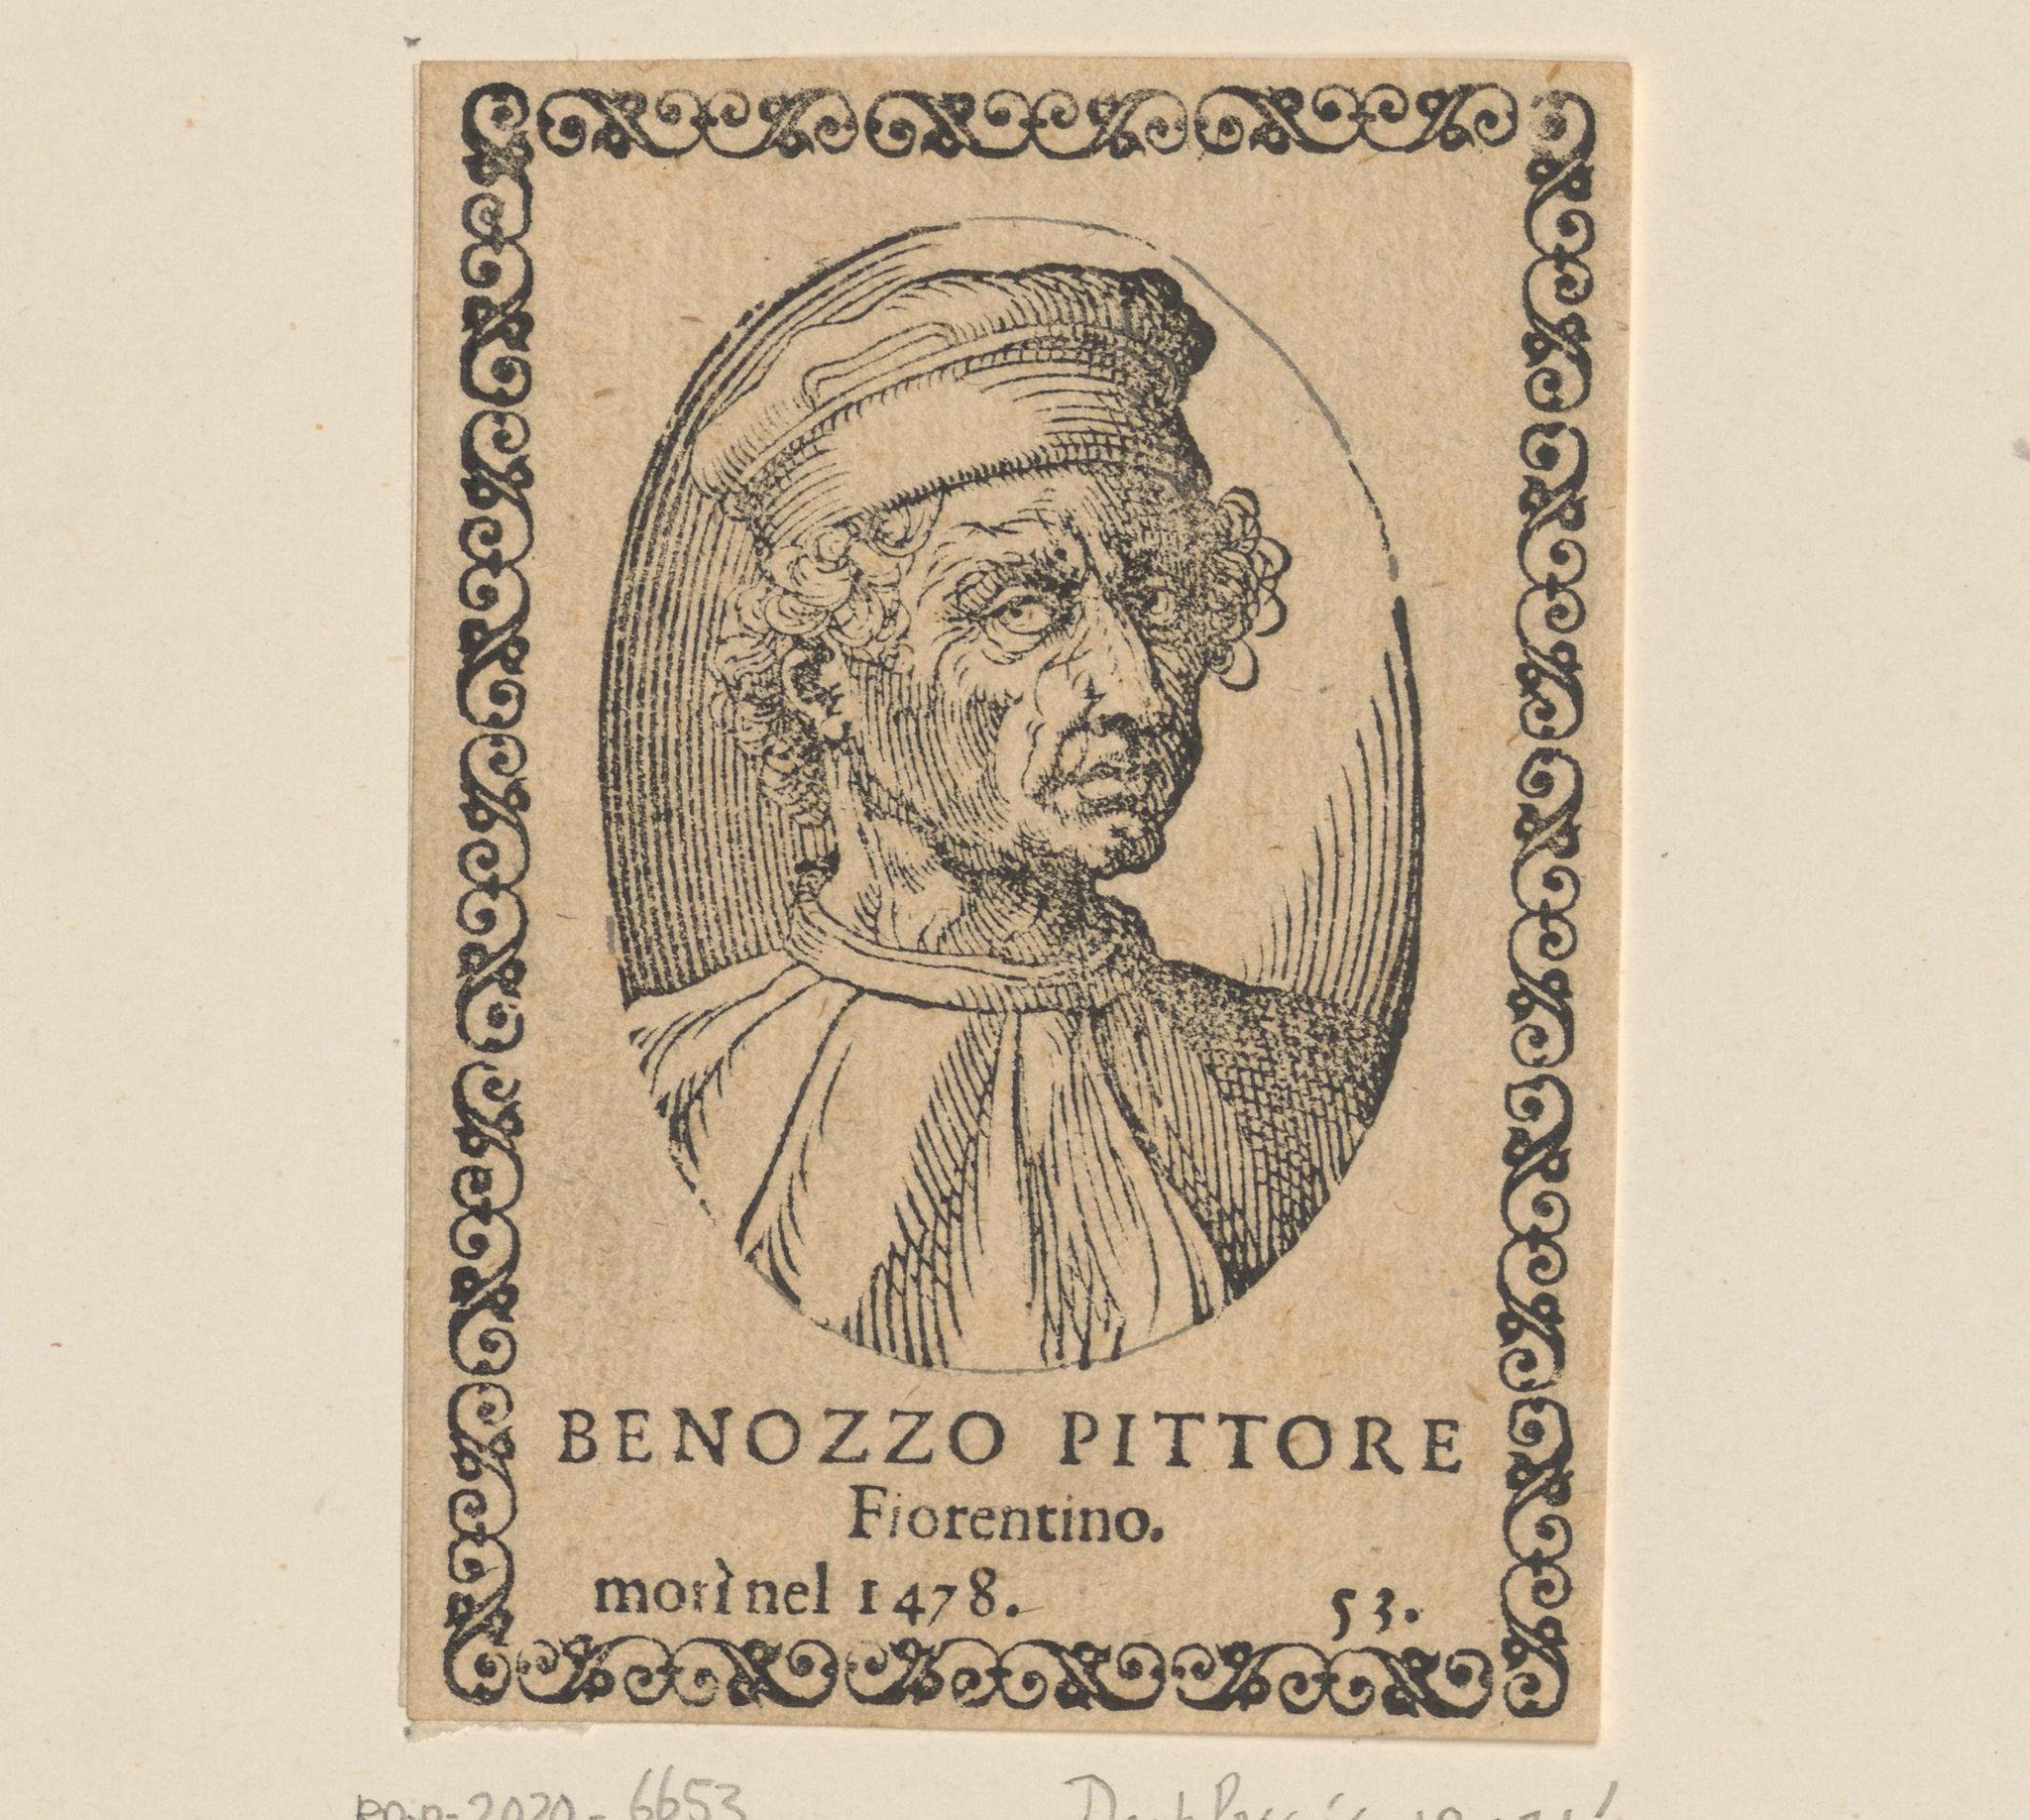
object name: print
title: Portret van Benozzo Gozzoli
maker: Anonymous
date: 1568-1650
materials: paper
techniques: letterpress printing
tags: painter, benozzo gozzoli, historical persons, portrait, self-portrait of painter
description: Prent uit een onbekende editie van: Vasari, Giorgio. Le Vite de' più eccellenti pittori, scultori, e architettori da Cimabue insino a' tempi nostri. S.l.s.n., [1568]. De prent is met een andere omlijsting gebruikt in de editie uit 1568, en mogelijk in de editie uit 1647.